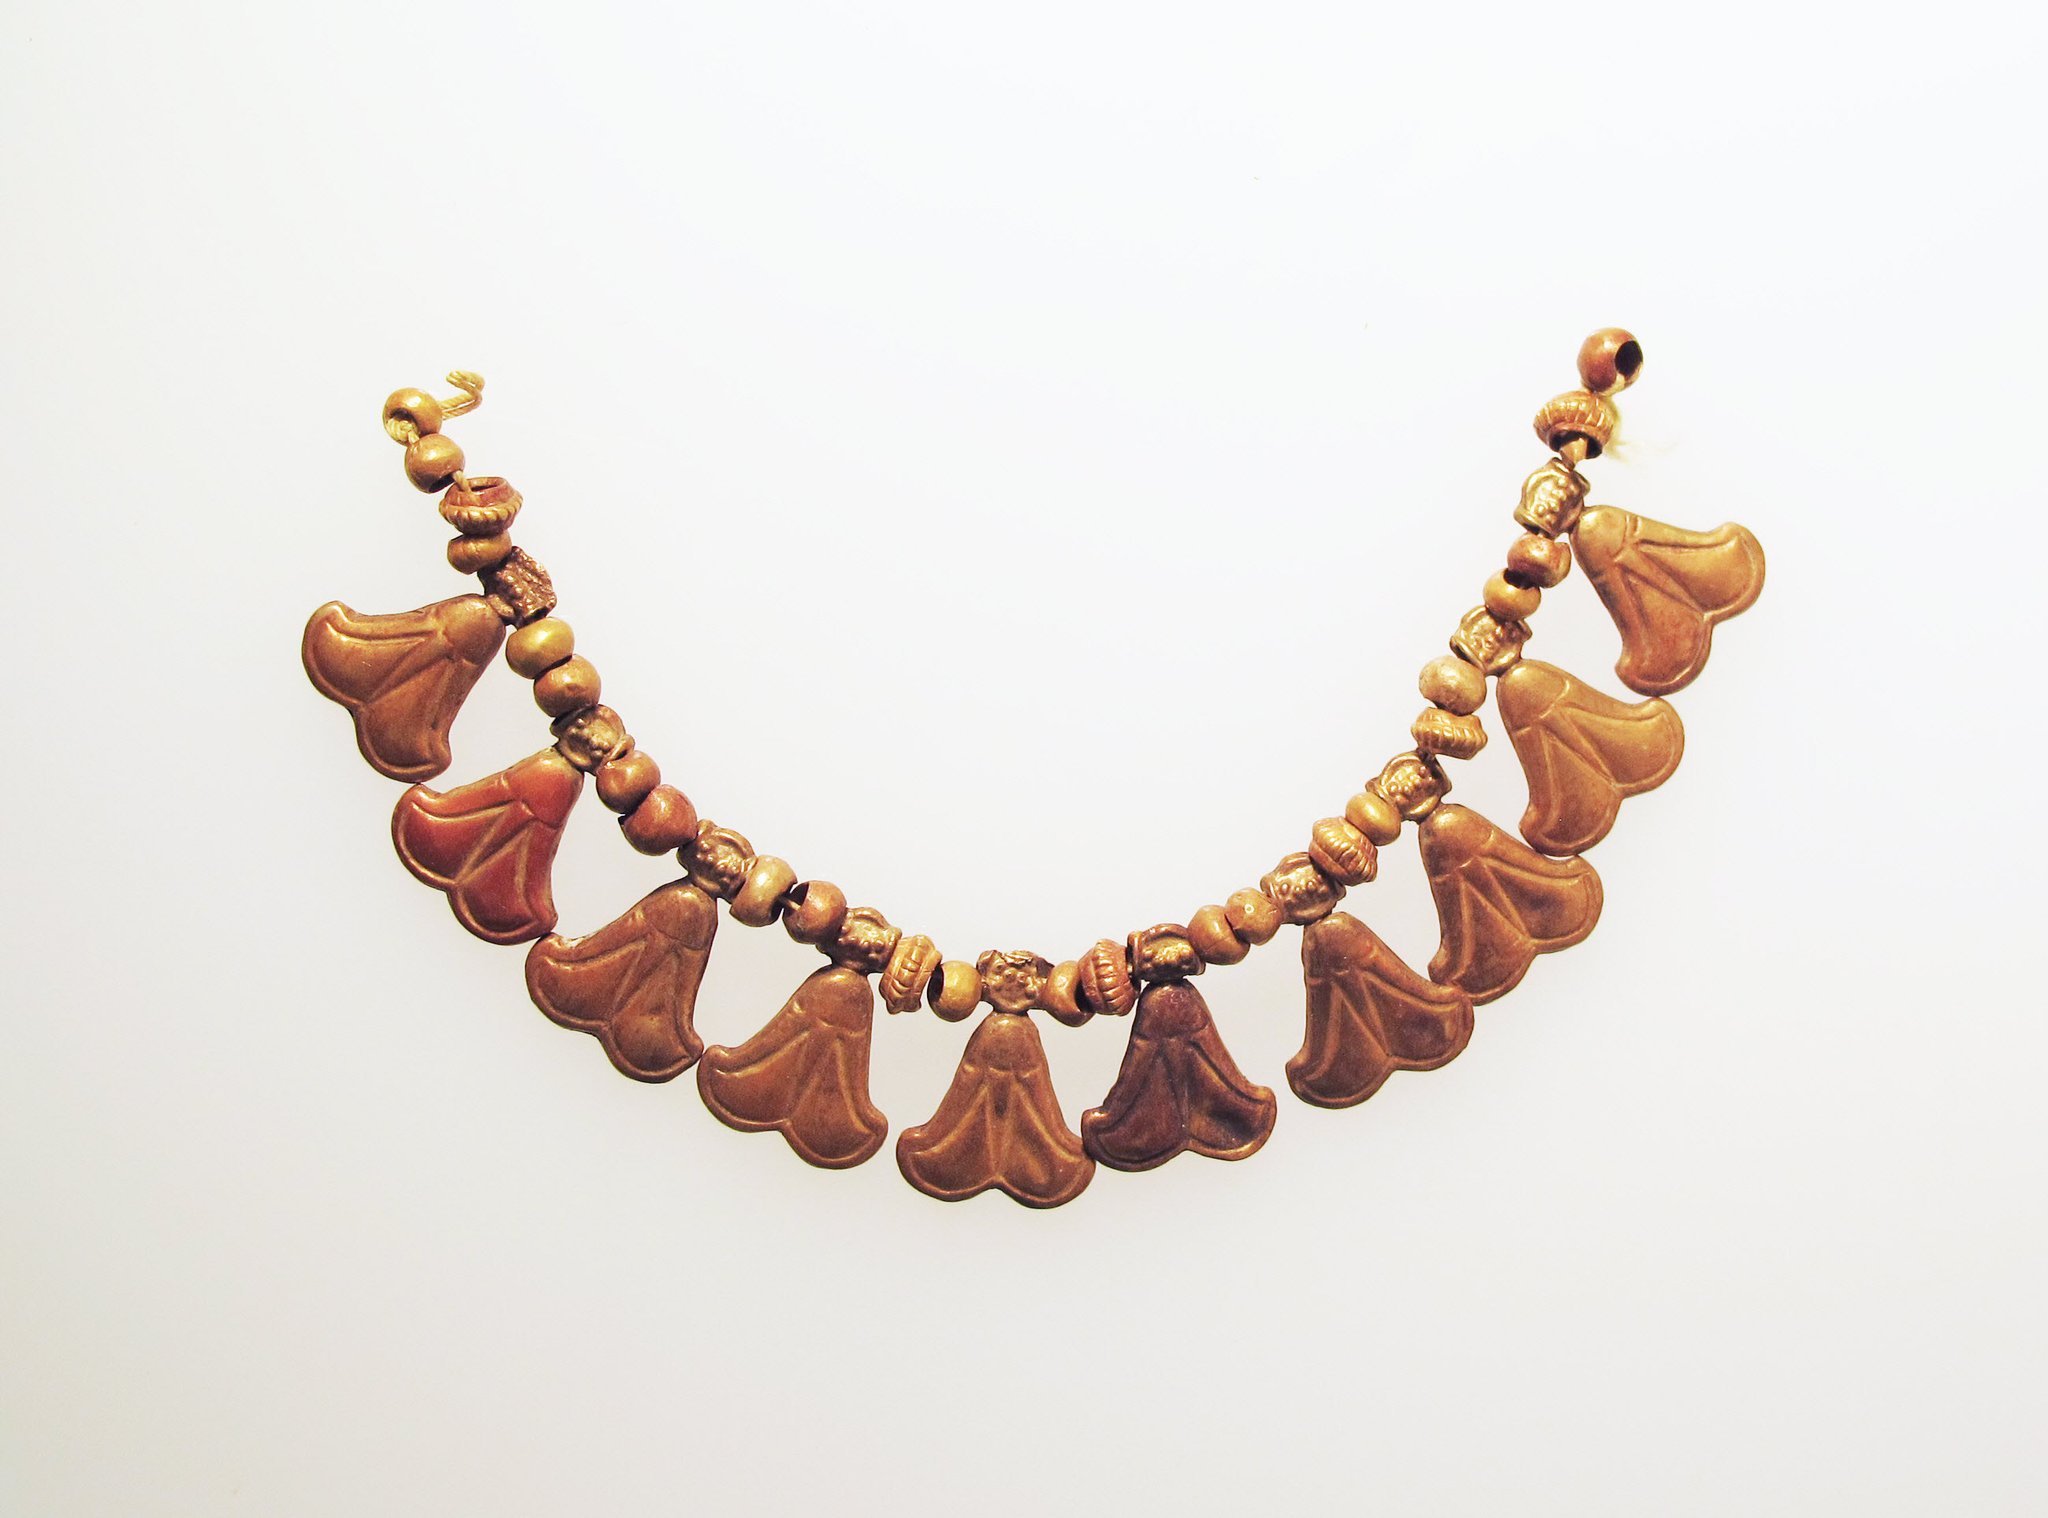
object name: bead pendant, with lotus flower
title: Bead pendant, with lotus flowers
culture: cypriot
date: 3900 BCE-100 CE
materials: gold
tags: lotuses